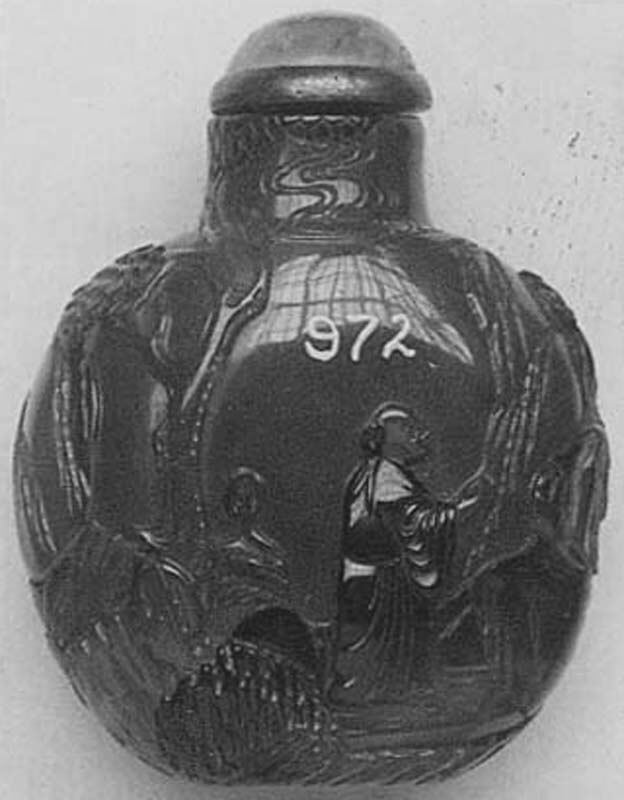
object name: snuff bottle with stopper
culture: chinese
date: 1701-1900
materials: stone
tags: human figures